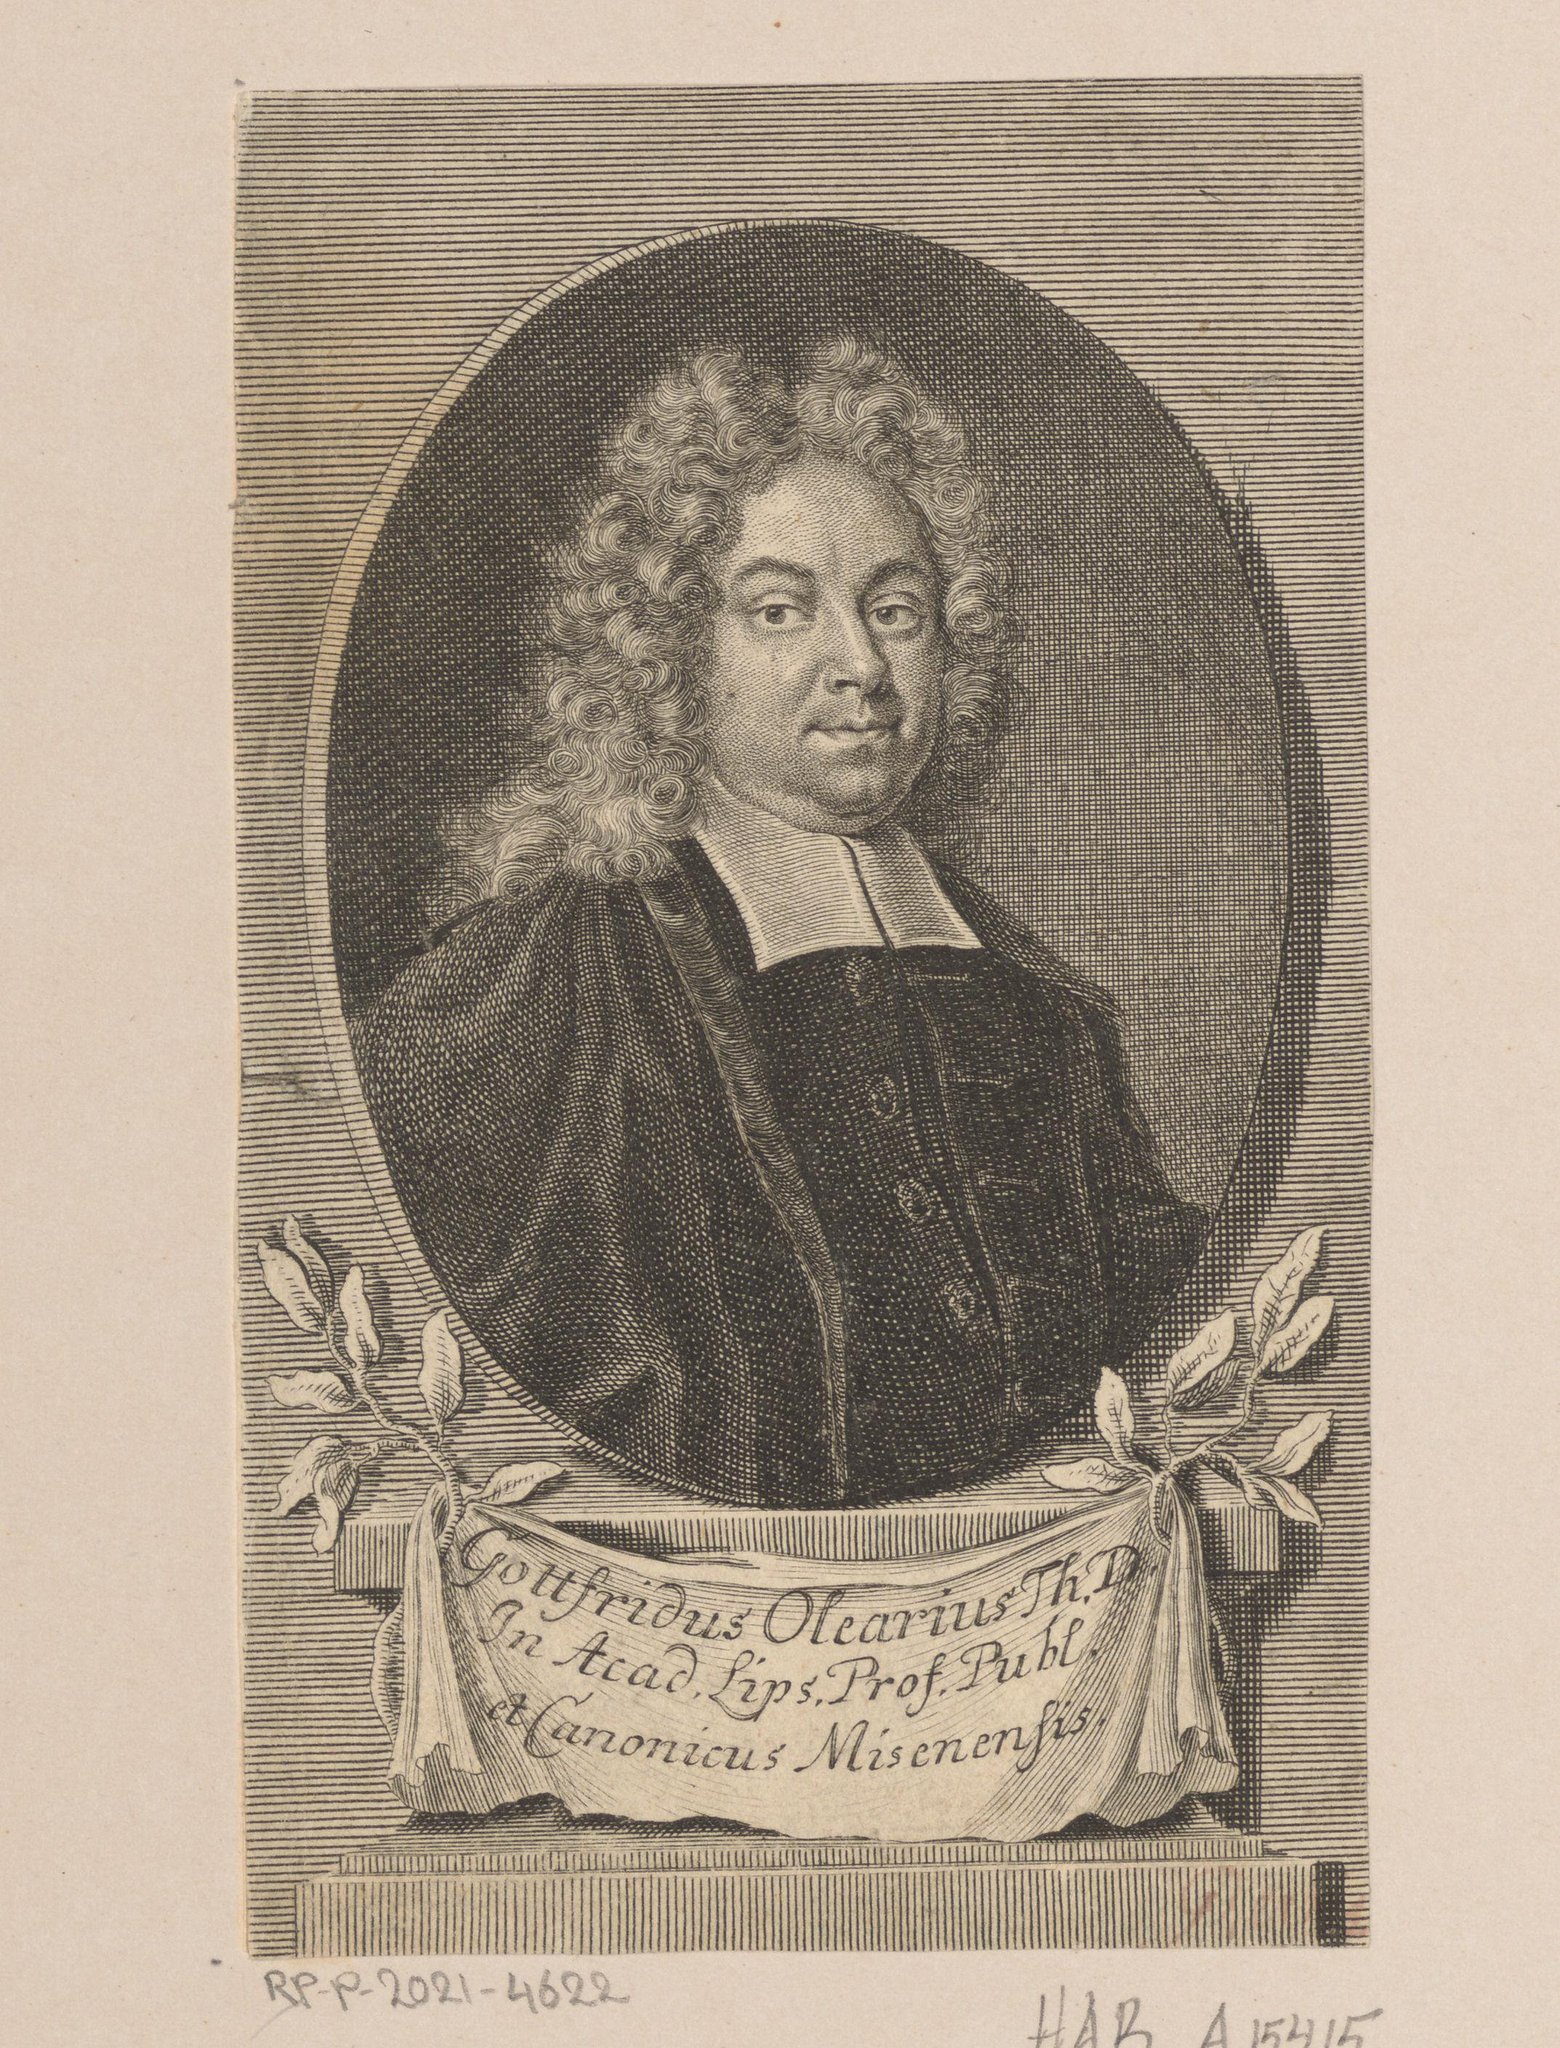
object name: print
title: Portret van Gottfried Olearius II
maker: martin bernigeroth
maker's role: print maker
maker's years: 1670-1733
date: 1713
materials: paper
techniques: engraving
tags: gottfried olearius (ii), historical persons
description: Prent mogelijk uit: Deutsche Acta Eruditorum (...). Leipzig: Johann Friedrich Gleditsch, 1713.